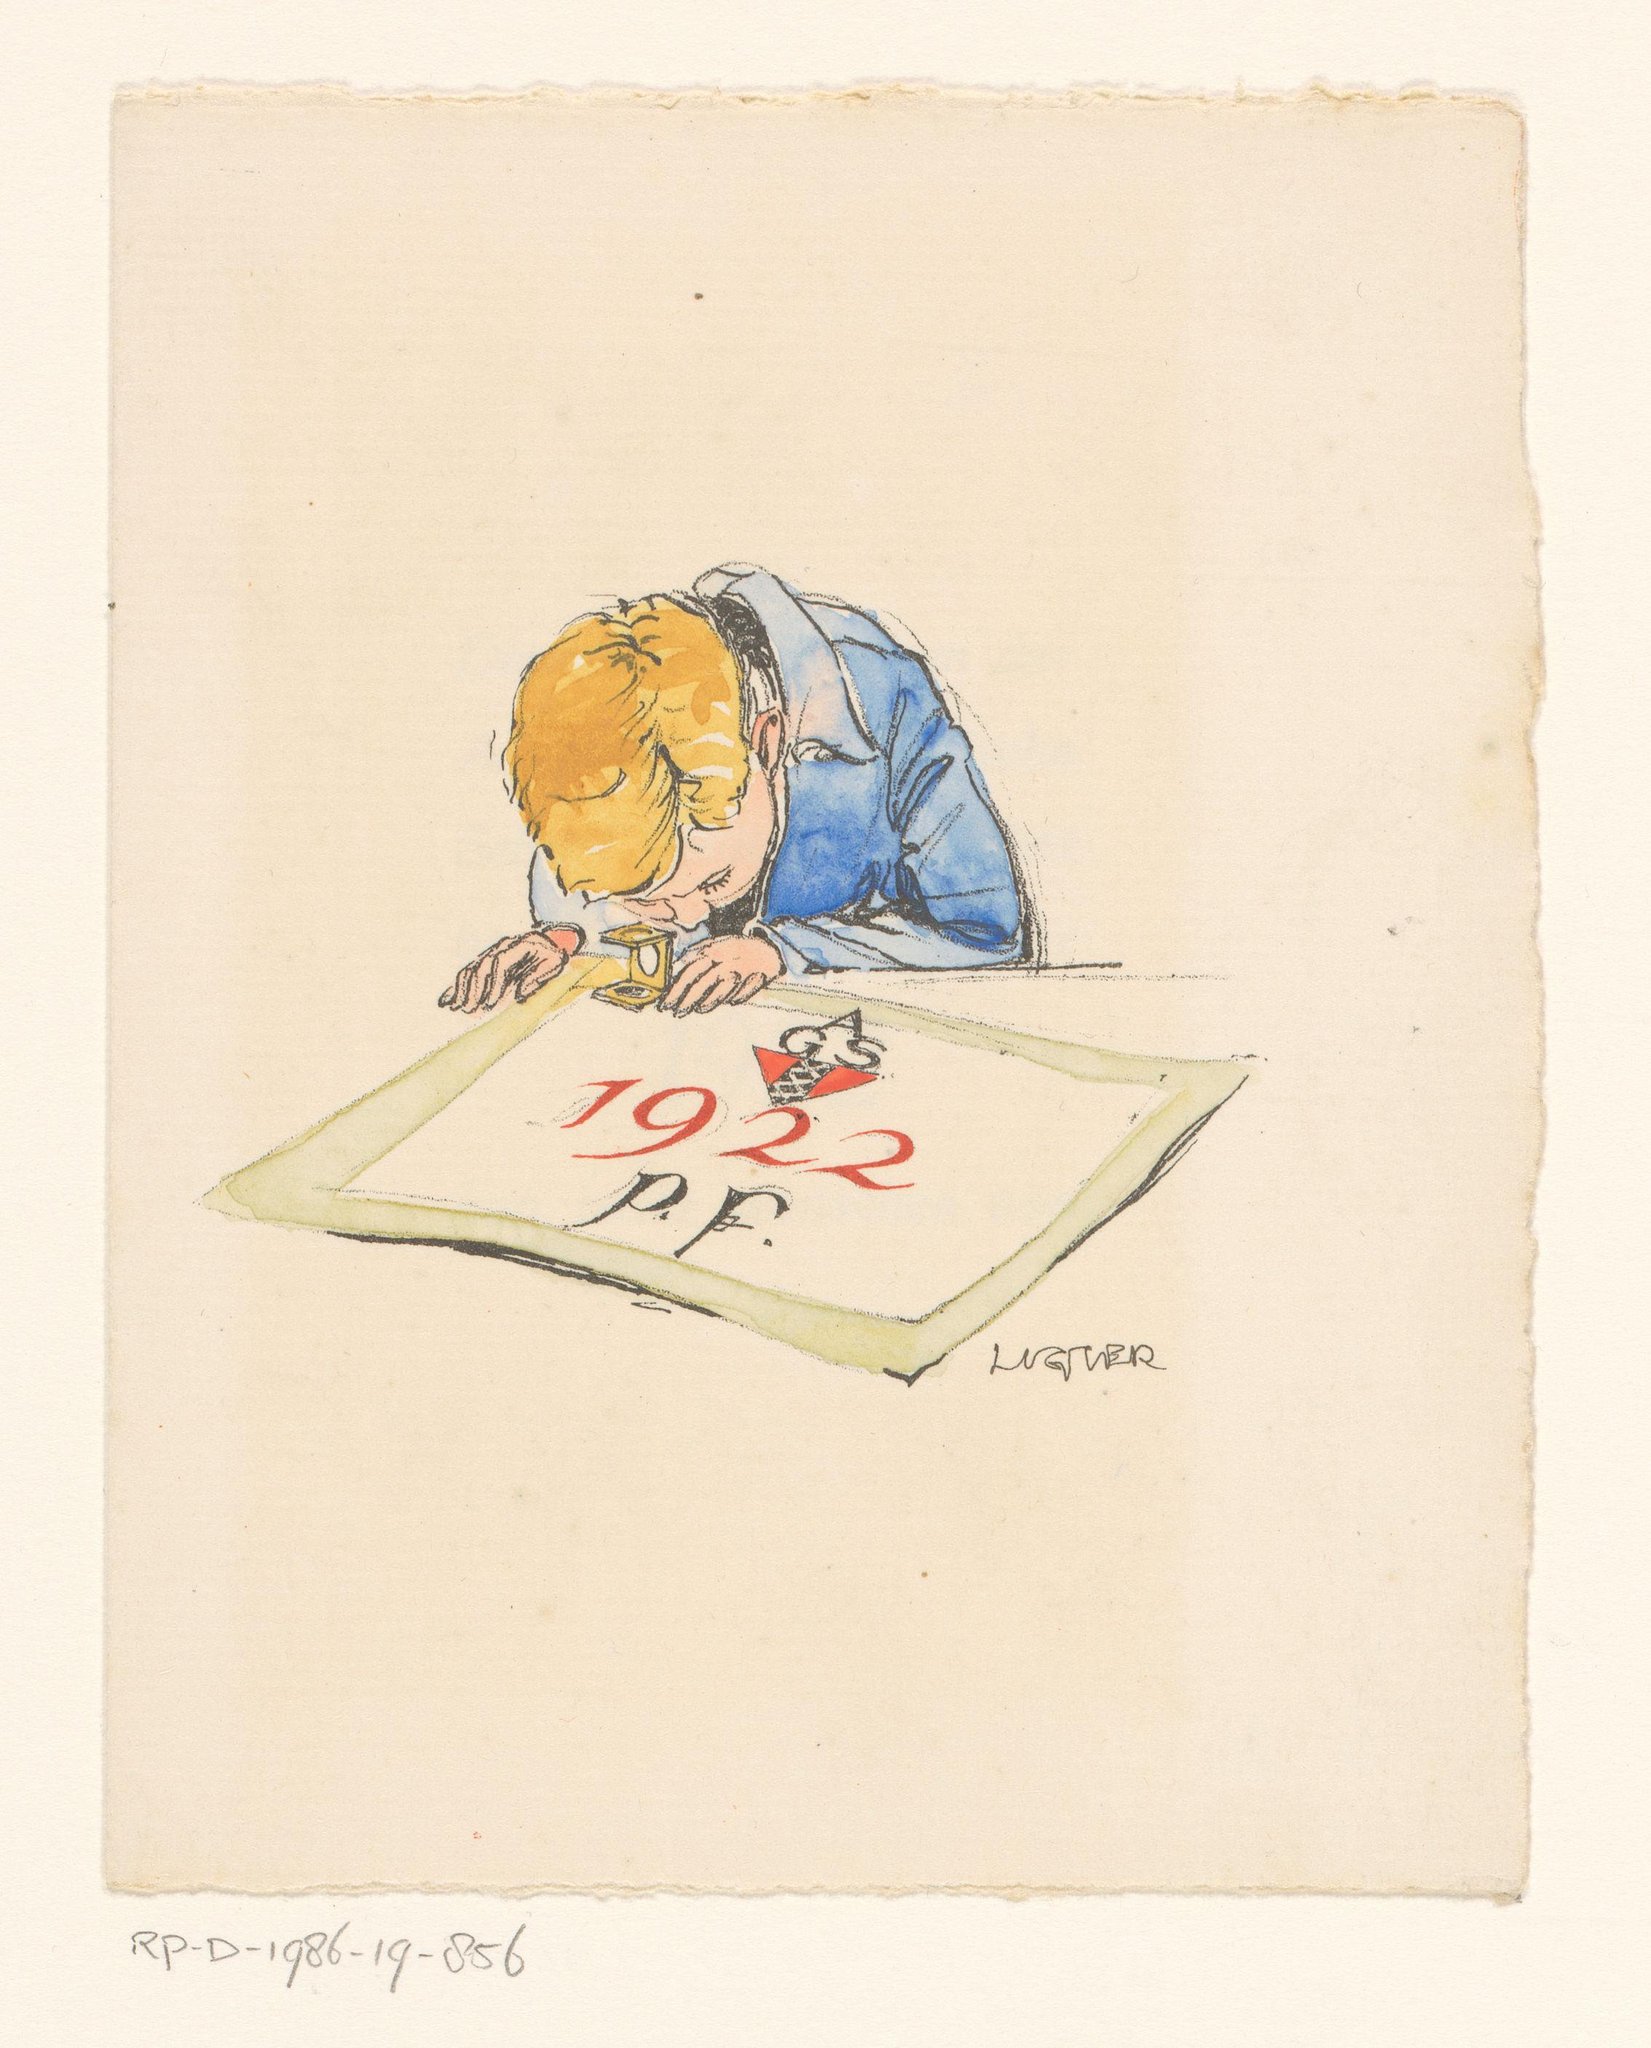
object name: print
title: Nieuwjaarswens van de Amsterdamsche Grafische School voor 1922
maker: jan ligter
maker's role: draughtsman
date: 1922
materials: paper, watercolor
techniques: brush, lithograph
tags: boy (child between toddler and youth), print, e.g.: engraving, etching, lithograph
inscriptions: date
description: Jongen bekijkt een prent met een dradenteller. Op de prent staat '1922', het wapen van Amsterdam en 'AGS'.